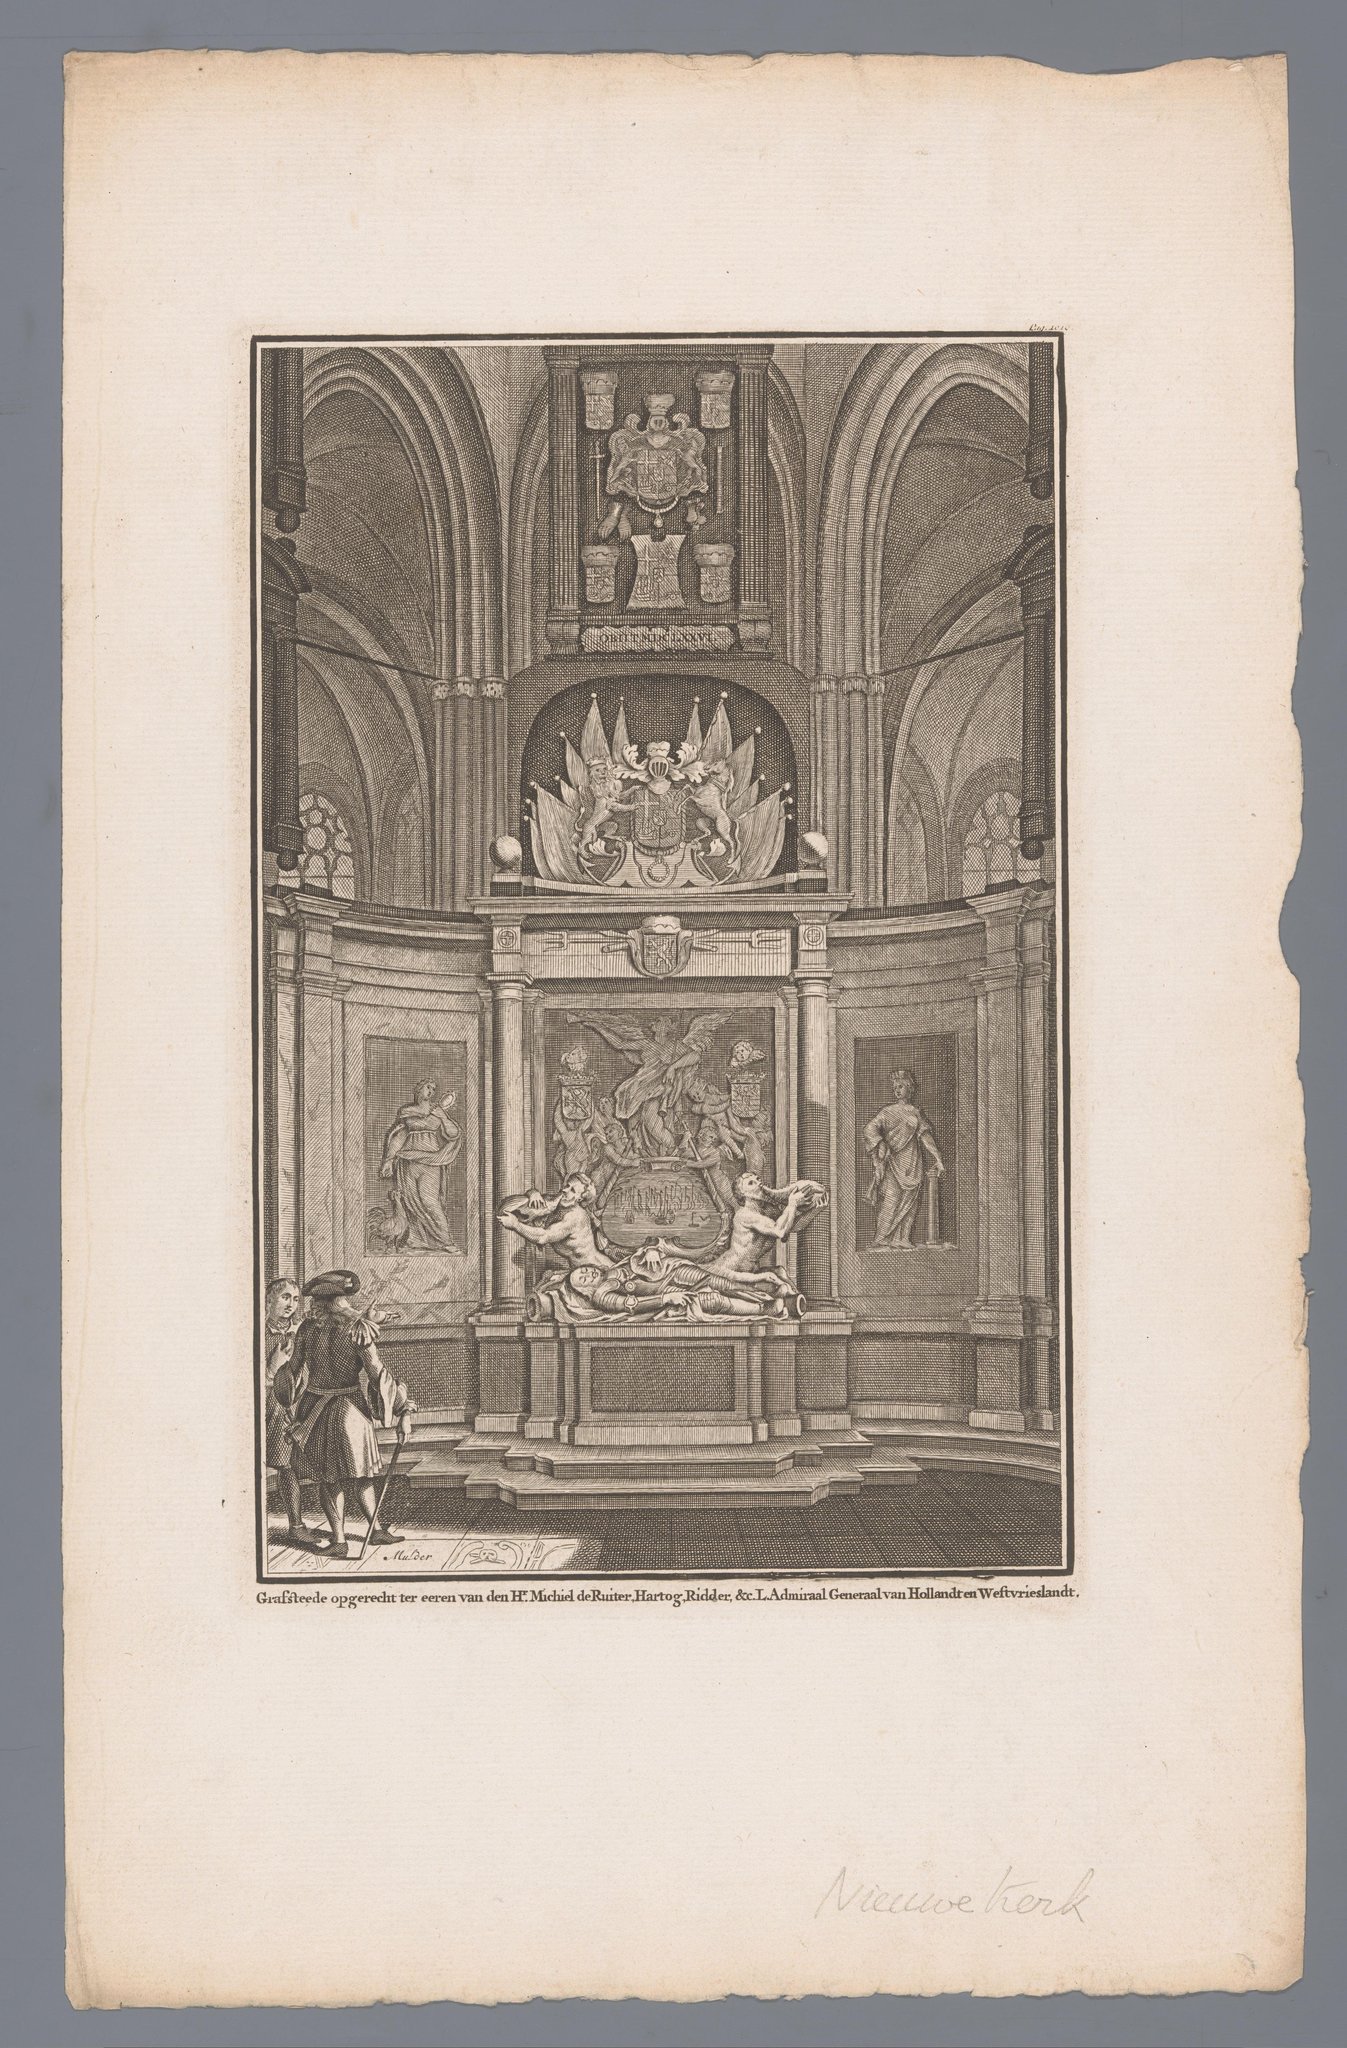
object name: print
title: Praalgraf van Michiel Adriaenszoon de Ruyter in de Nieuwe Kerk te Amsterdam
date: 1687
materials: paper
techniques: engraving, etching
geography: amsterdam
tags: flushing, michiel adriaenszoon de ruyter, interior of church, grave-building, monumental tomb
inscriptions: collector's mark: Lugt 2228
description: Prent voor het eerst gebruikt in: Brandt, Geeraert. Het leven en bedryf van den heere Michiel de Ruiter, Hertog, Ridder &c. L. Admiraal Generaal van Hollandt en Westvrieslandt. Amsterdam: Abraham Wolfgang et al., 1687, p. 101. Ook gebruikt in heruitgaven van dit werk en 1691 en 1701. Ook gebruikt in: Commelin, Caspar. Beschryvinge van Amsterdam, desselfs eerste oorspronk uyt den Huyse (…). Amsterdam: Abraham Wolfgang et al., 1693. En in heruitgaven van dit werk in 1694 en 1726.